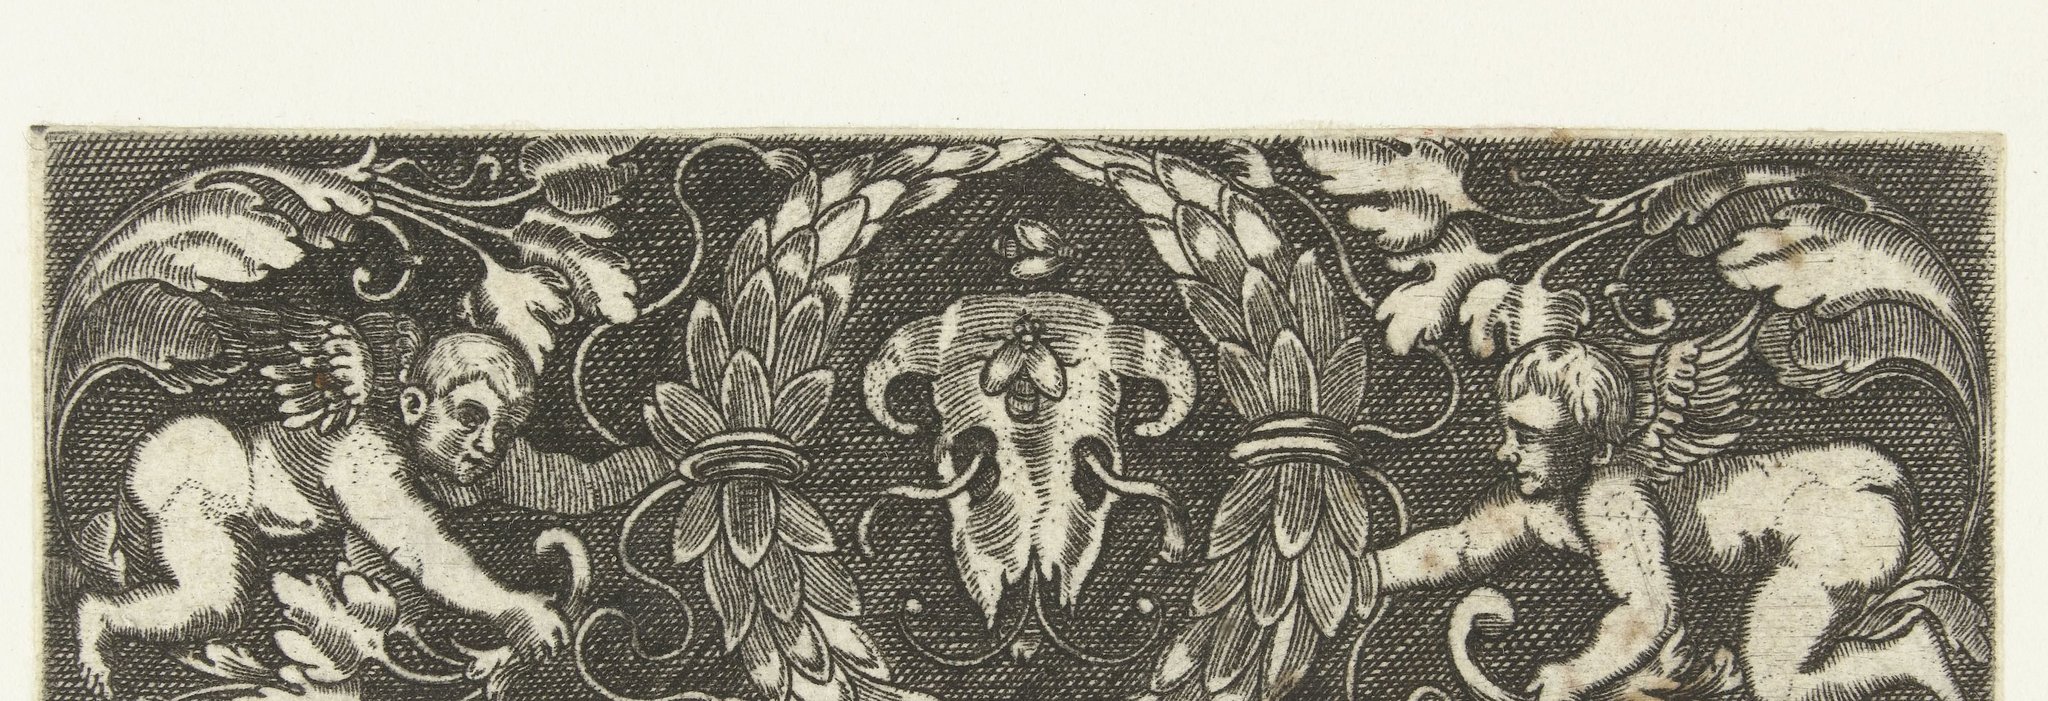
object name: ornament print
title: Fries met de schedel van een dier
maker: Anonymous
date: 1500-1600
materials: paper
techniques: engraving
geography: germany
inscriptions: collector's mark: Lugt 240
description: Twee putti houden een lauwerkrans rond de schedel vast.